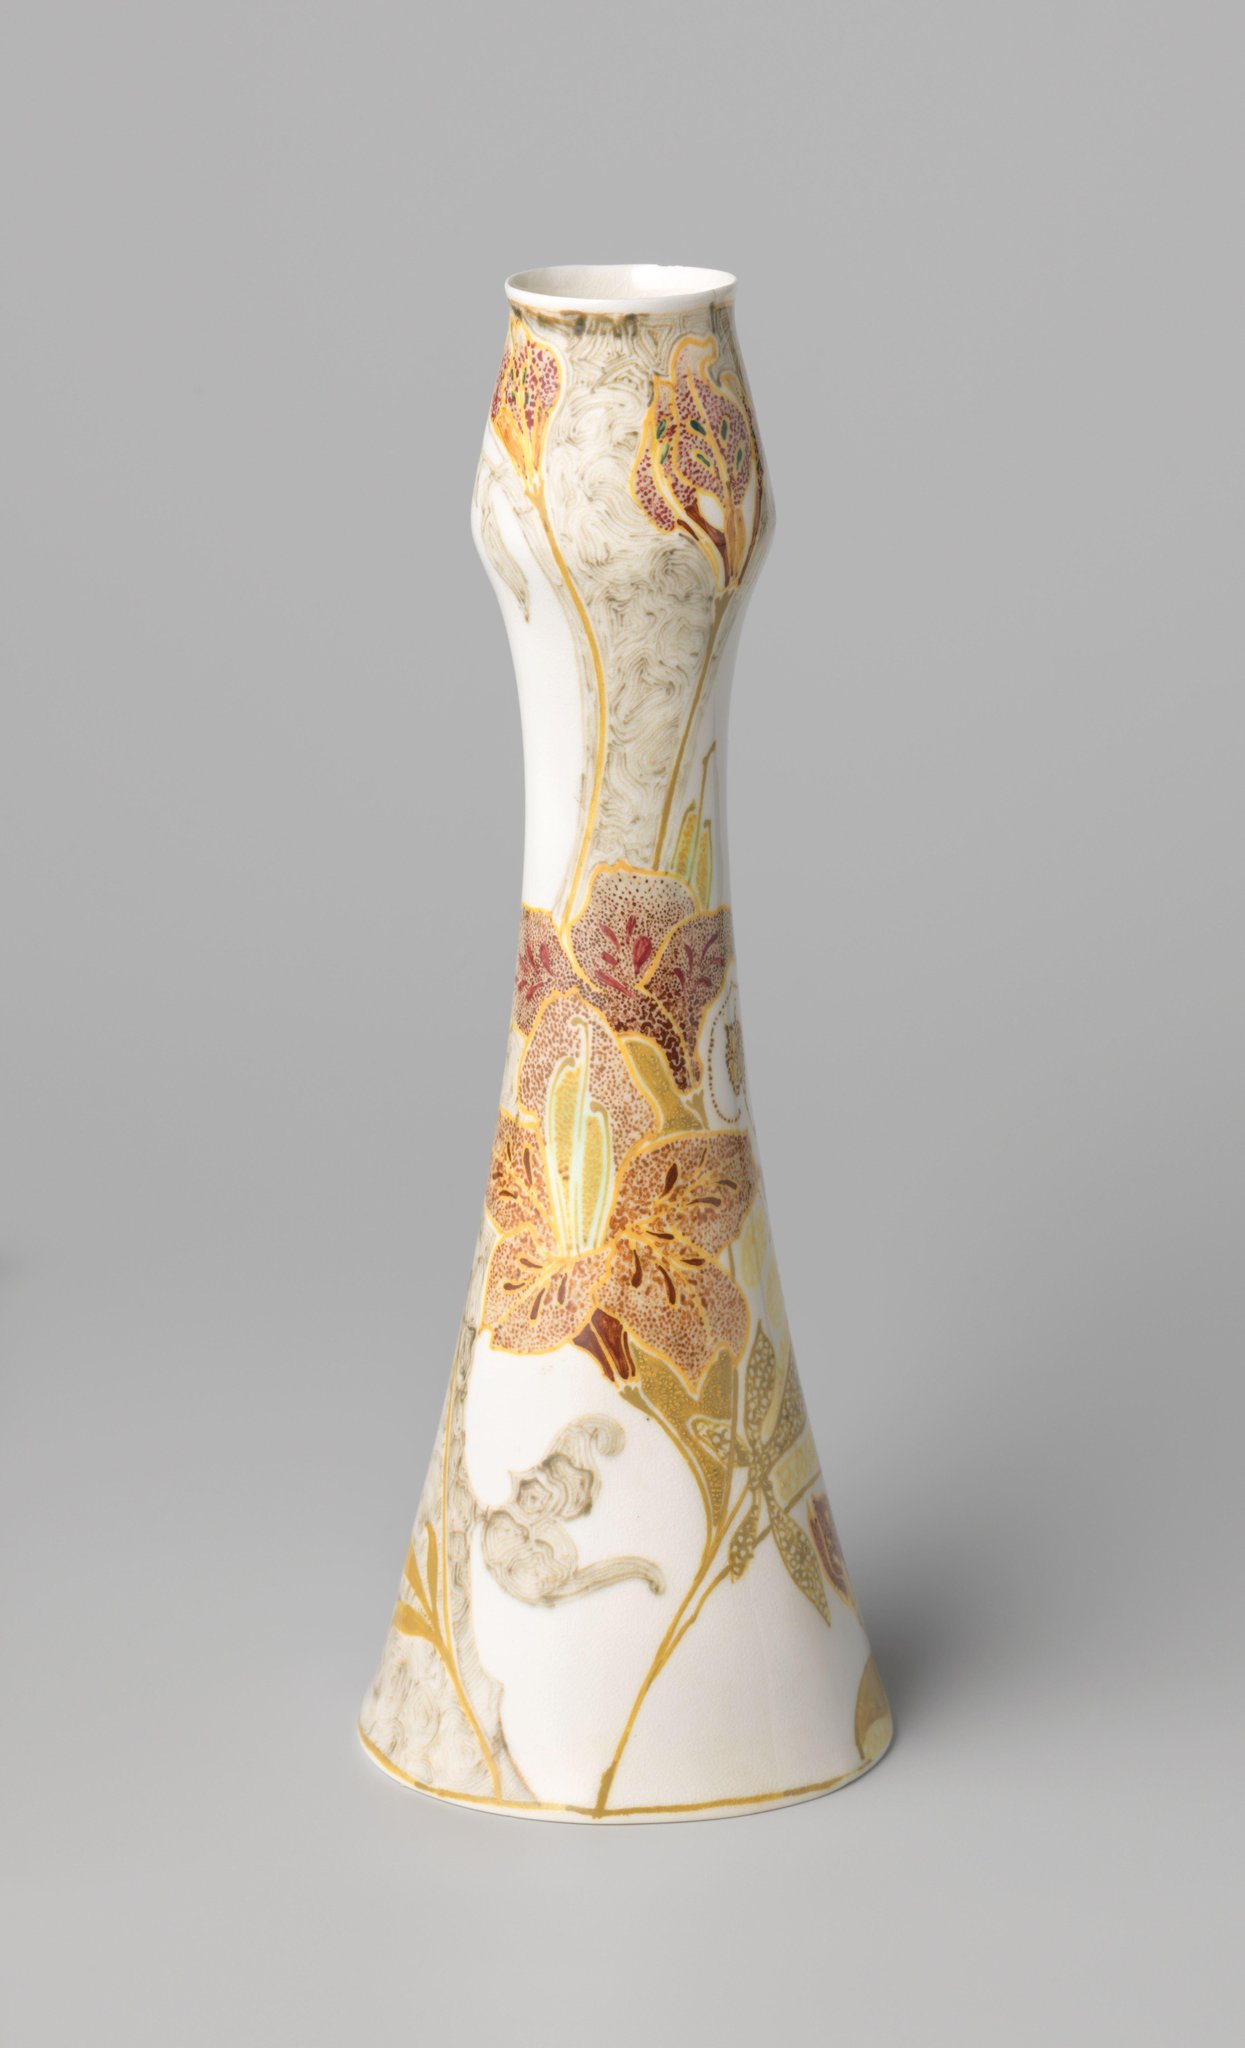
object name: vase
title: Vaas van porselein, cilindervormig, met verdikking onder mondrand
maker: roelof sterken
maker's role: porseleinschilder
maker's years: 1877-1943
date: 1903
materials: porcelain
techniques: painted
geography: the hague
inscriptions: mark: ‘kroon // Rozenburg // ooievaar // den Haag (in grijsgroen) ; ster ; werkordernummer 105 ; schildersmerk RS (alles in zwart)’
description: Vaas van porselein, cilindervormig, naar boven toe zich sterk verjongend, met drie centimeter onder de mondrand een verdikking. Beschilderd in groen, geel, rood en grijs met ornamentale rangschikking. Model 135.